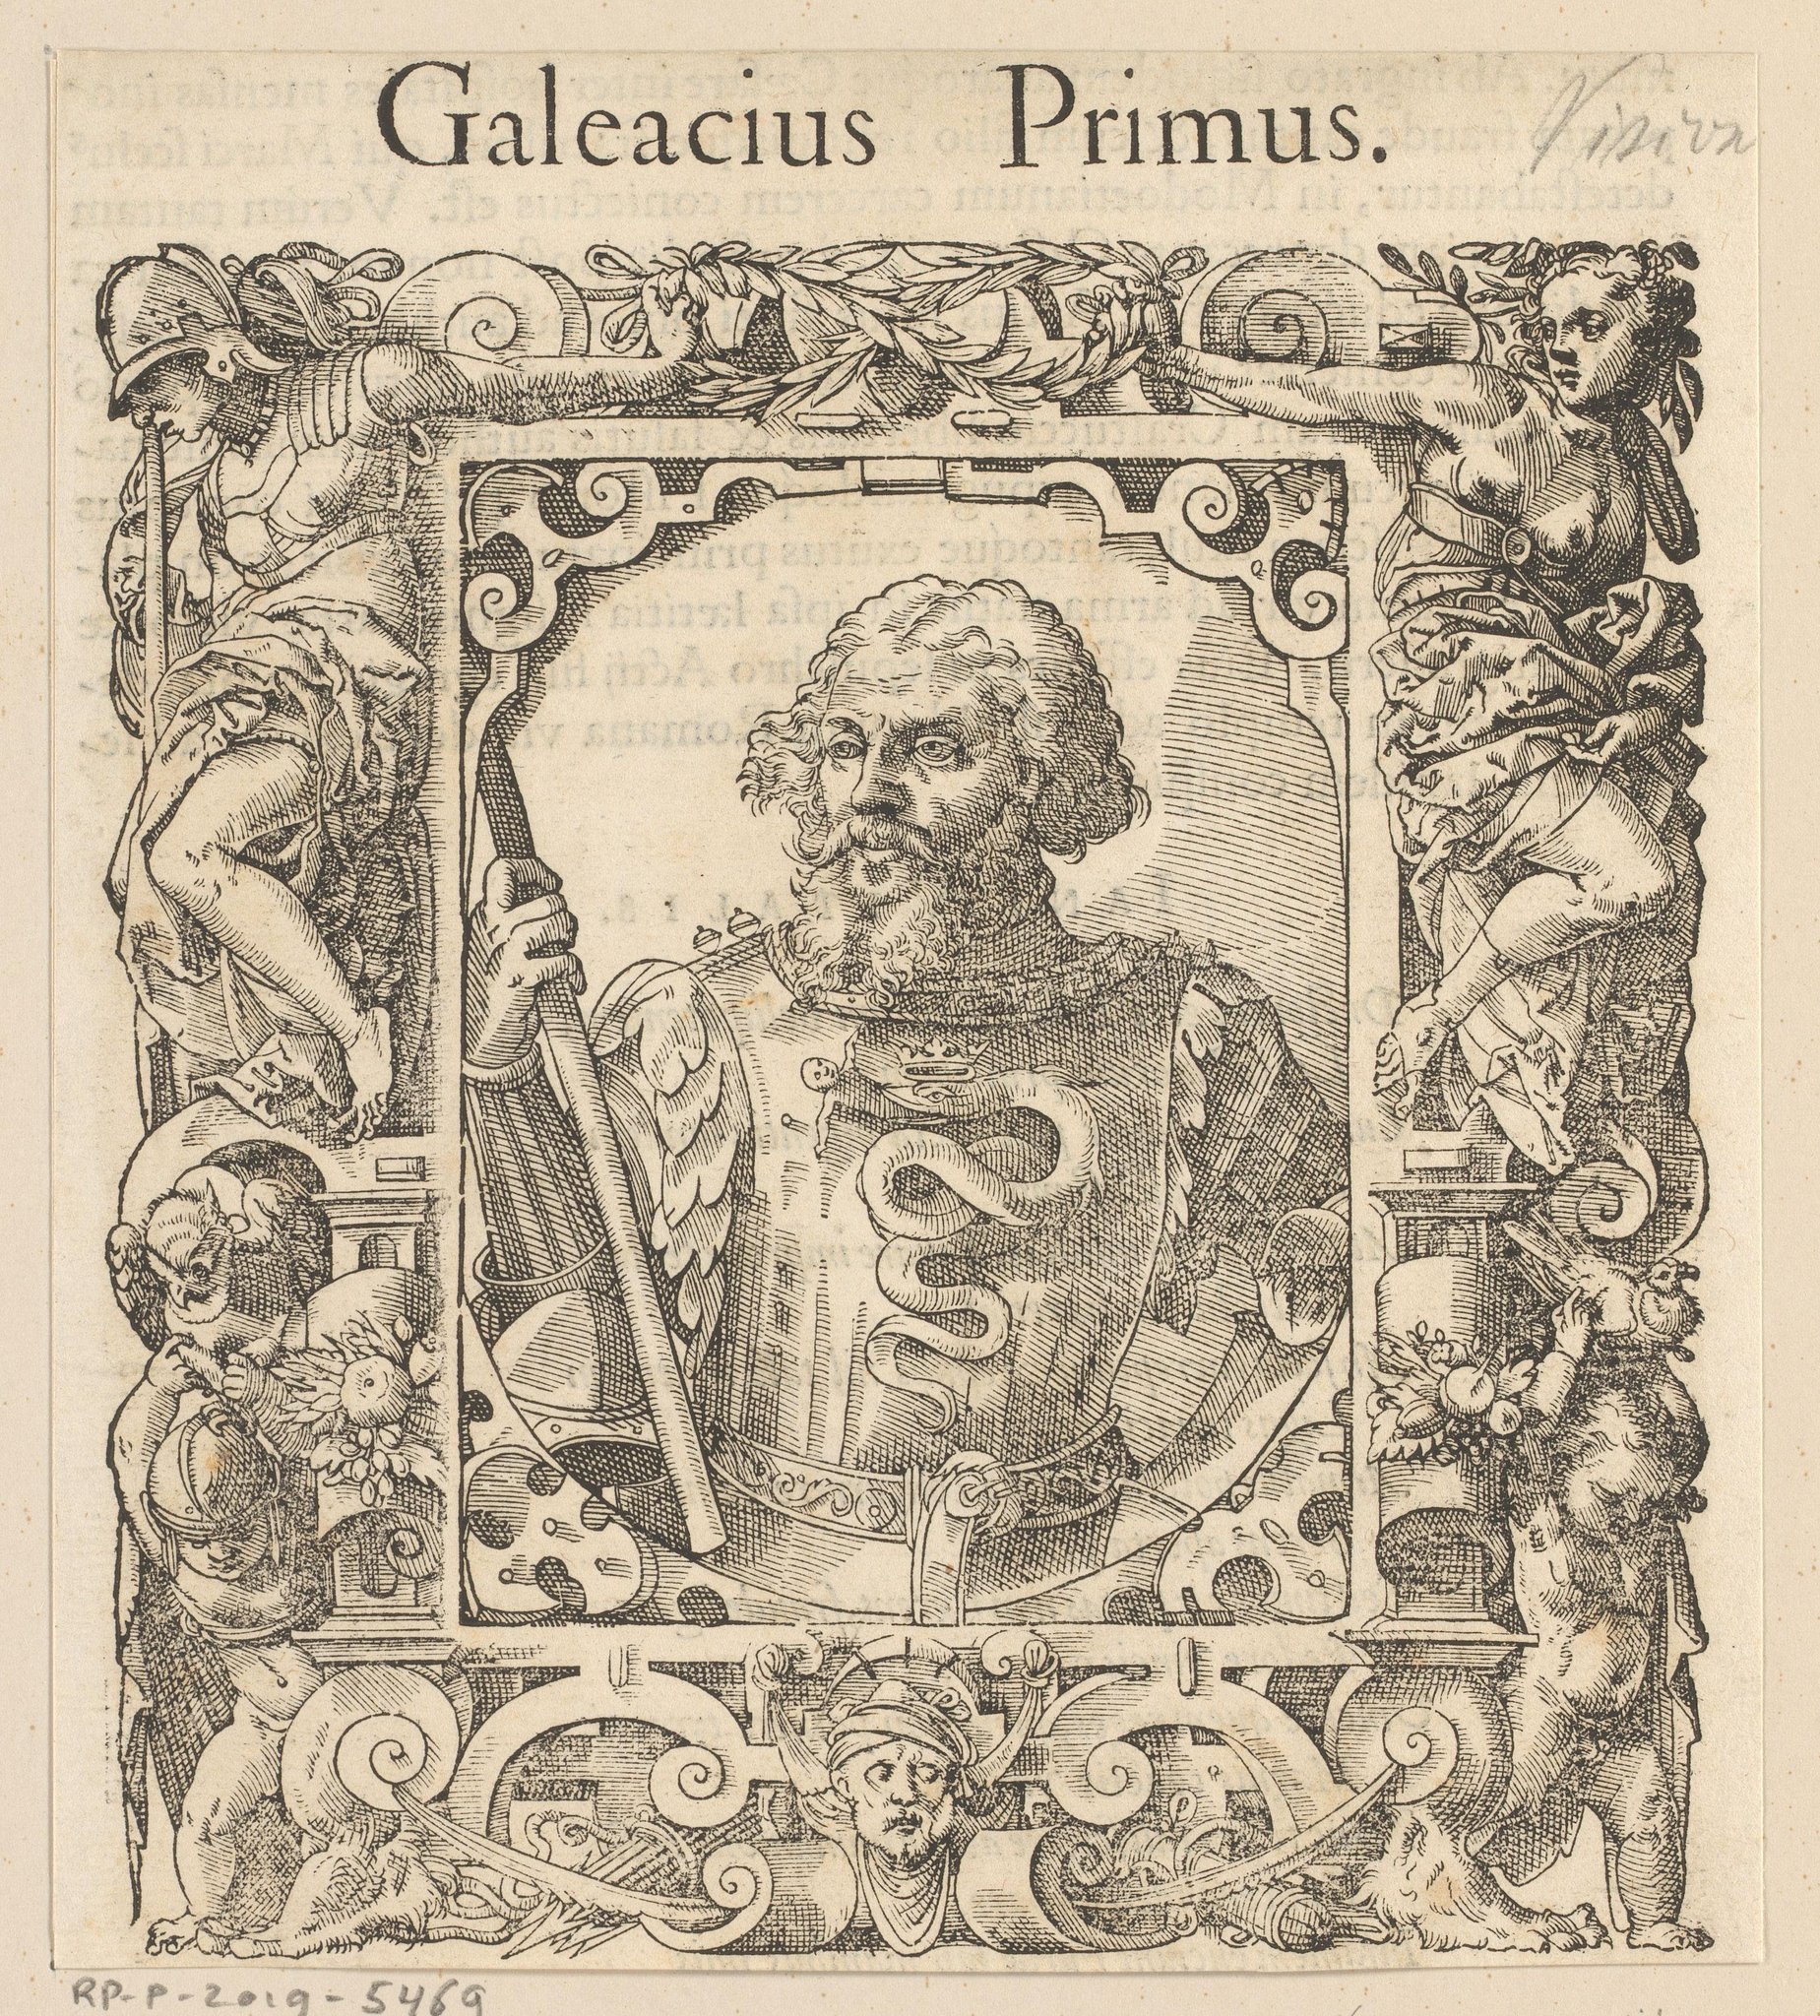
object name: print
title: Portret van Galeazzo I Visconti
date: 1575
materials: paper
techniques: letterpress printing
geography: basel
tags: historical persons, baton of general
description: Prent uit: Giovio, Paolo. Elogia virorum bellica virtute illustrium (...). Bazel: Peter Perna, 1575, p. 75. Prent ook gebruikt in latere publicaties.